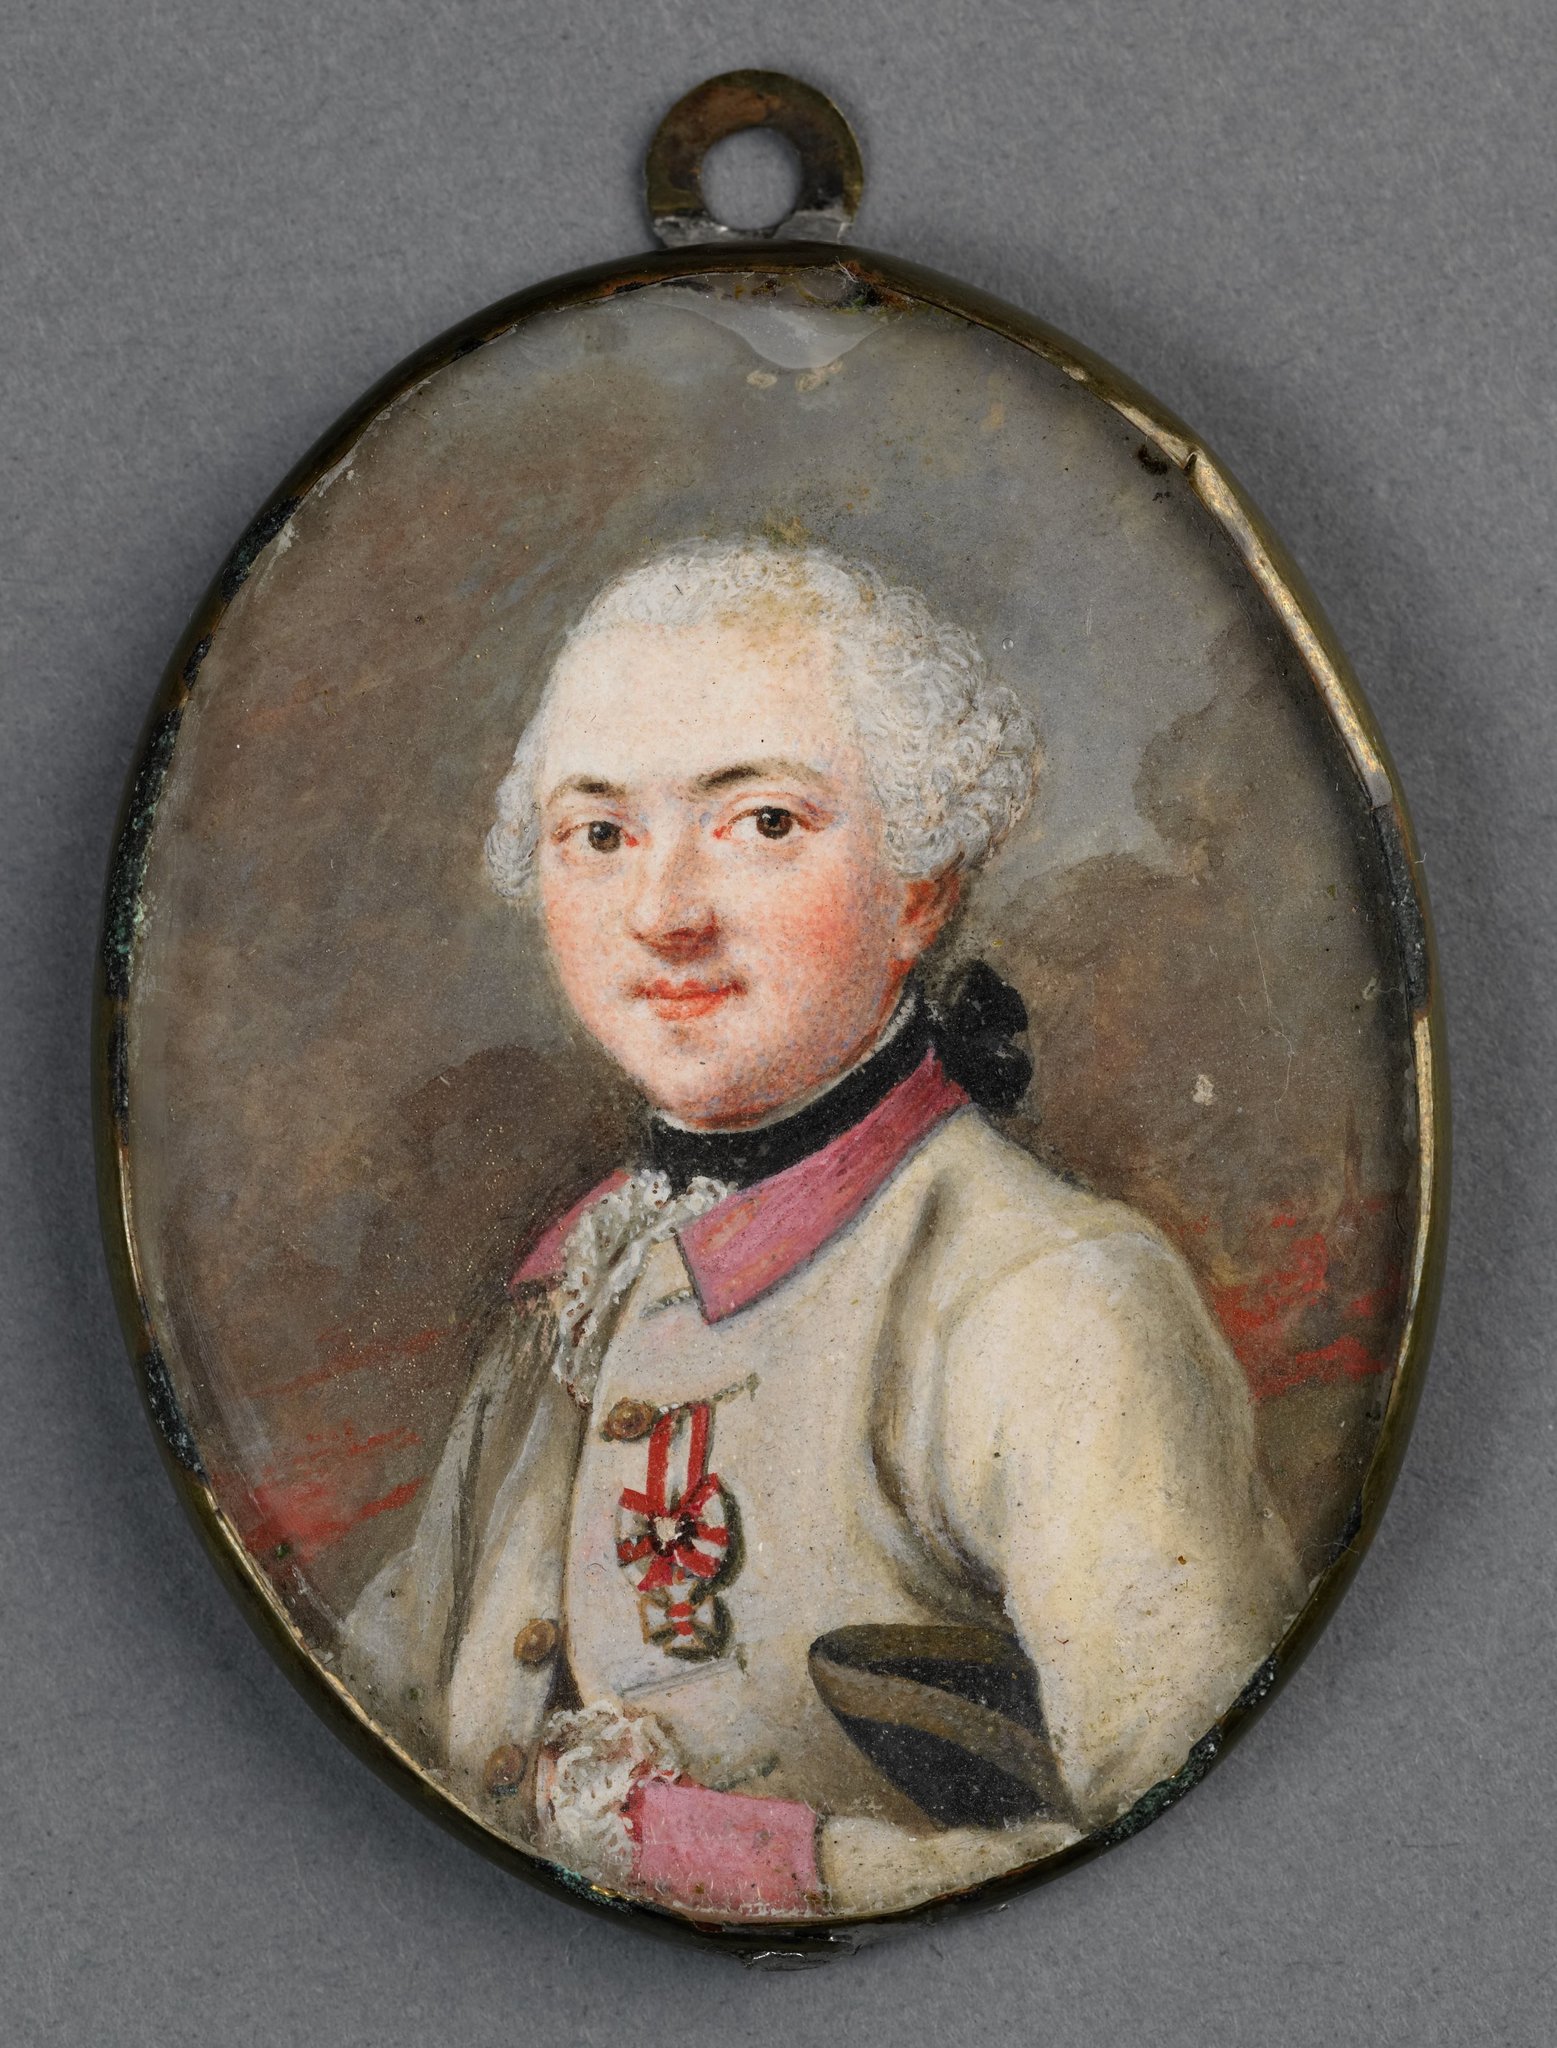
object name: painting, miniature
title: Portret van een Oostenrijkse officier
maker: Anonymous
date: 1770-1790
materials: cardboard, glass, metal, watercolor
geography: germany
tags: historical persons not known by name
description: Portrait of an Austrian Officer. German school. Board, c. 1780. Baron F.G.S. van Brakell bequest, Arnhem, 1878.